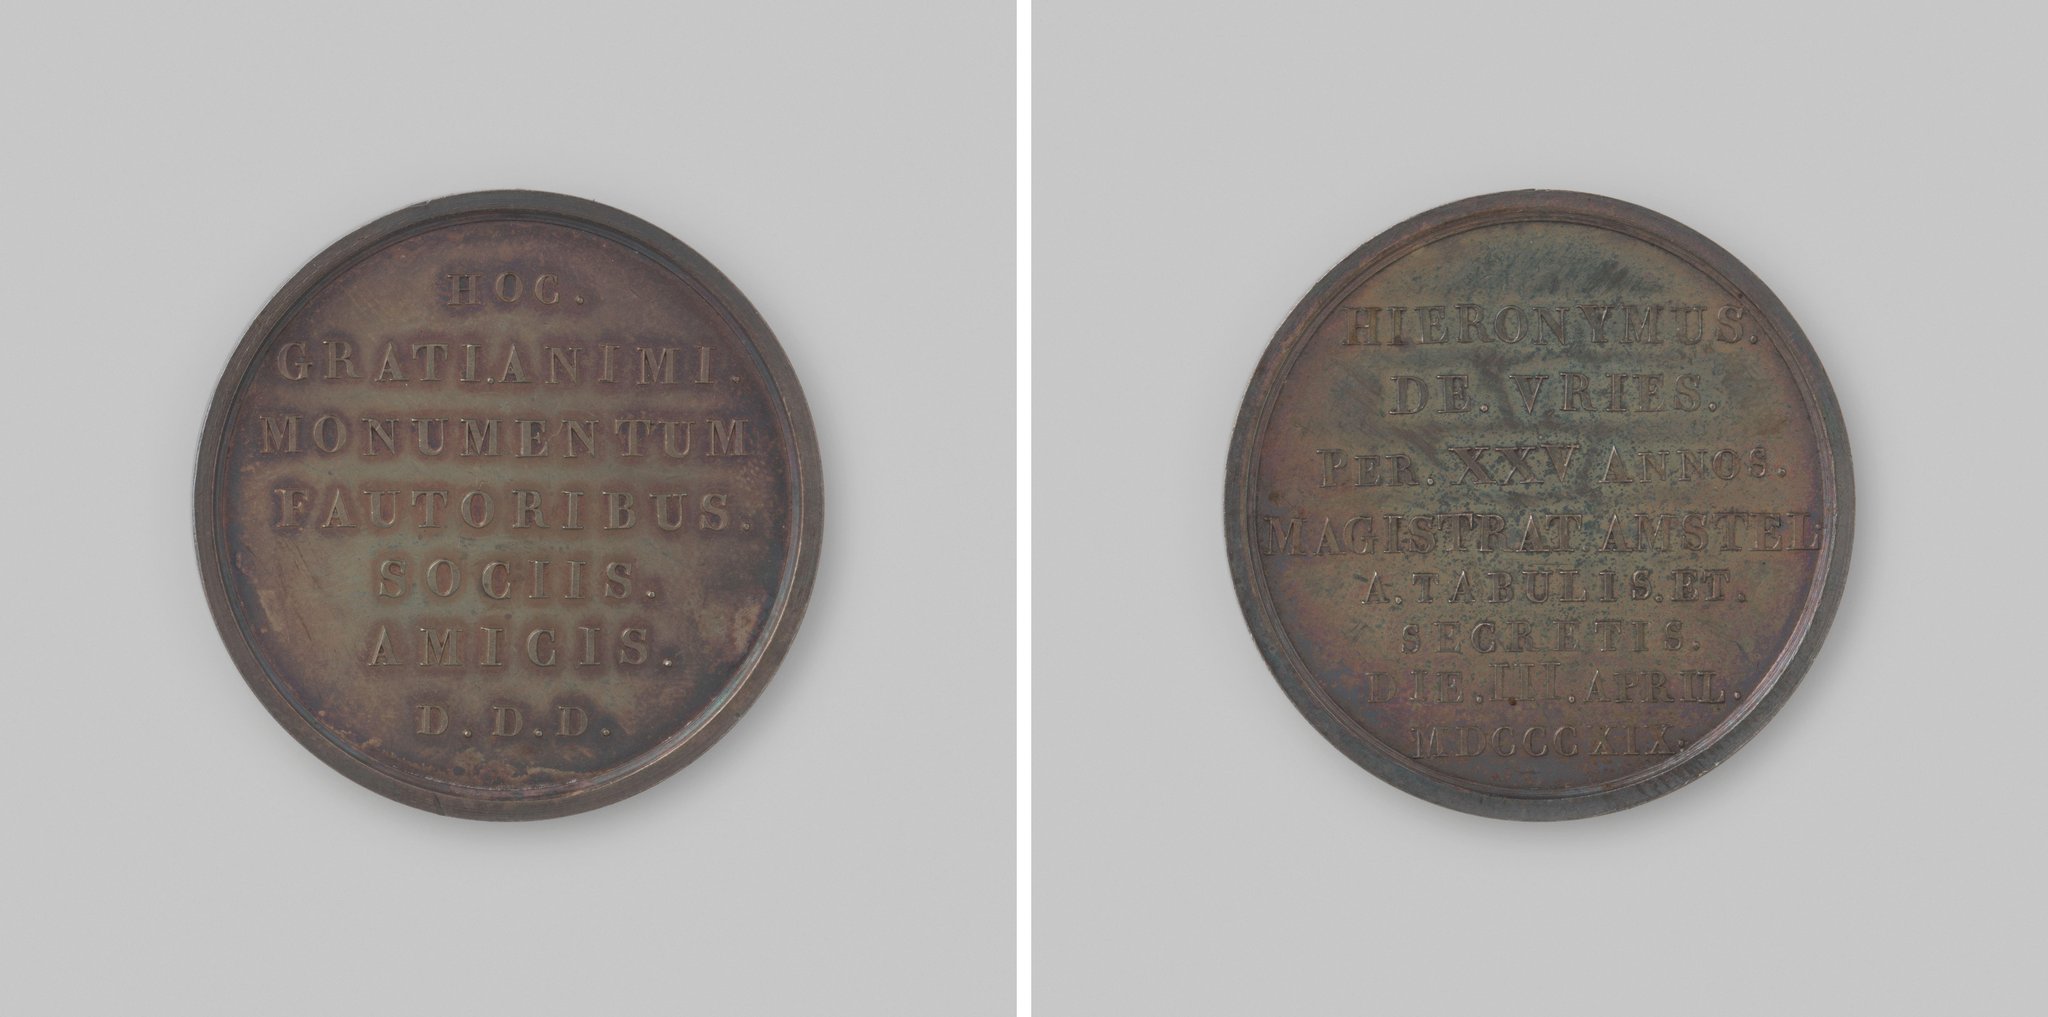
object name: history medal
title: Jeronimo de Vries vijfentwintig jaar Secretaris van Amsterdam 1819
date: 1819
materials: silver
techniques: striking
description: Zilveren penning, op de voorzijde zeven, op de keerzijde acht regels tekst.